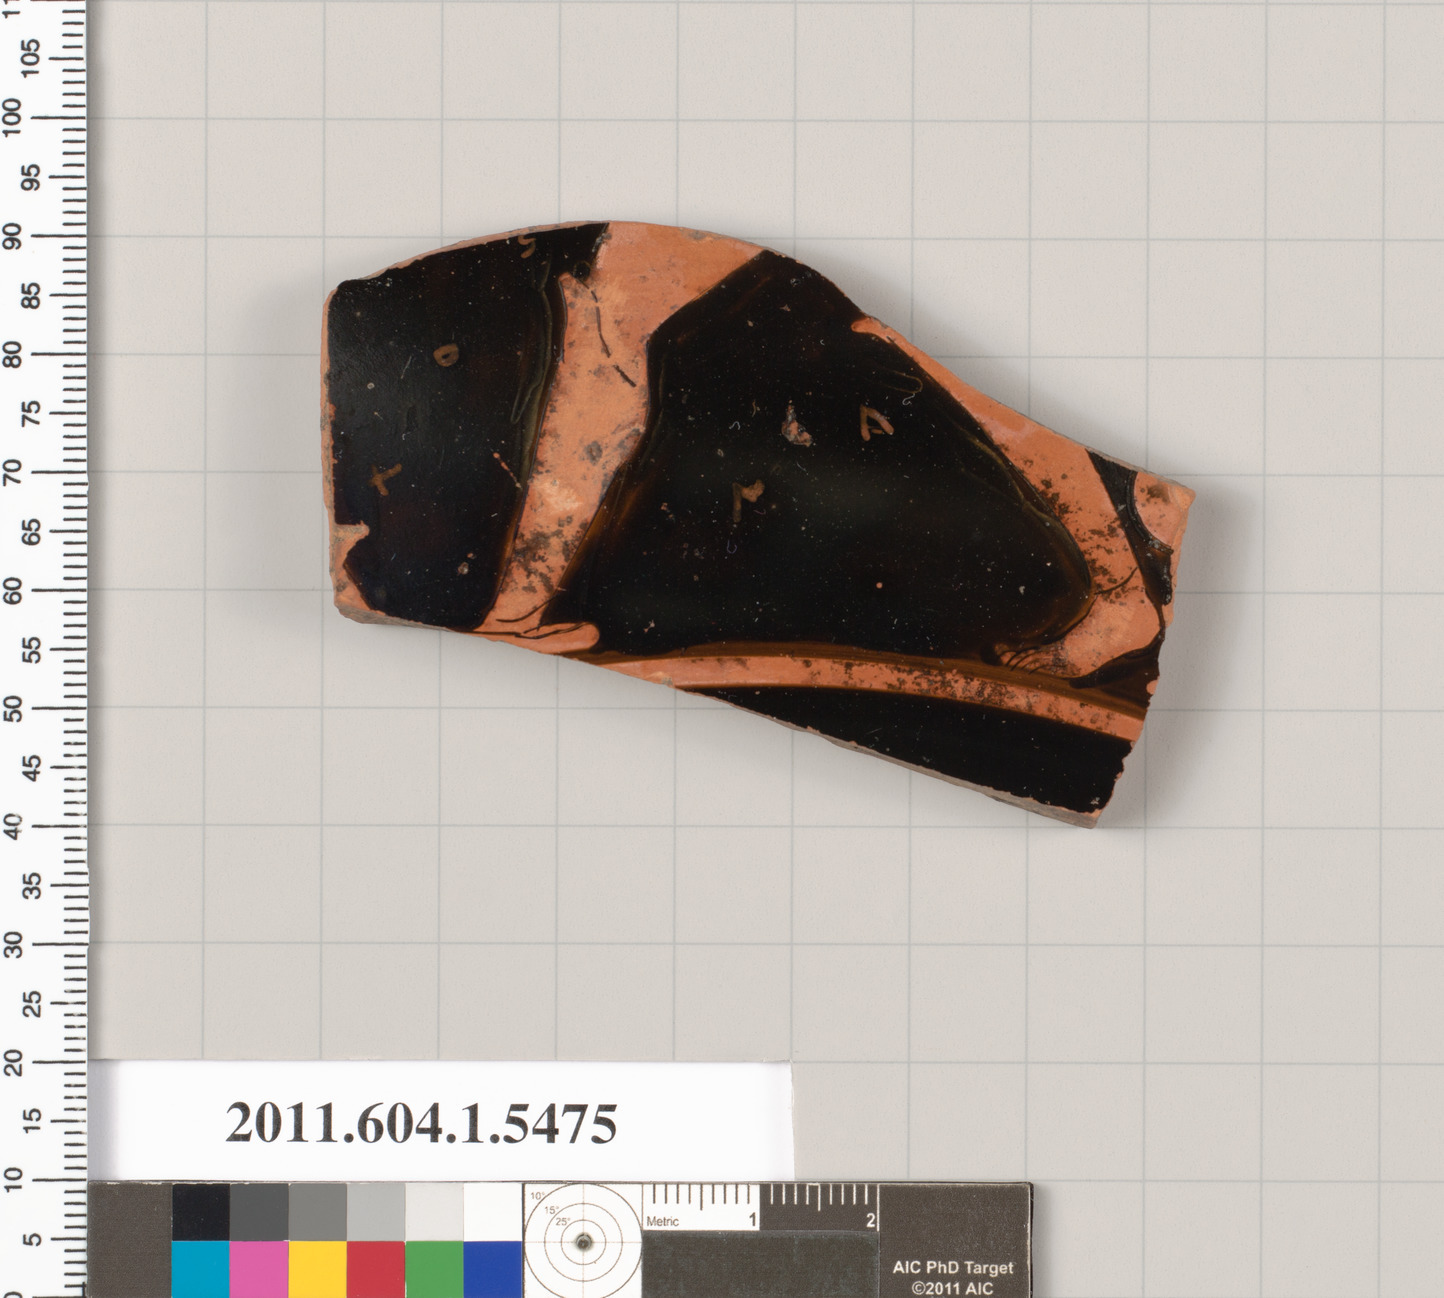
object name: kylix fragment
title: Terracotta fragment of a kylix (drinking cup)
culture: greek, attic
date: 520-500 BCE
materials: terracotta